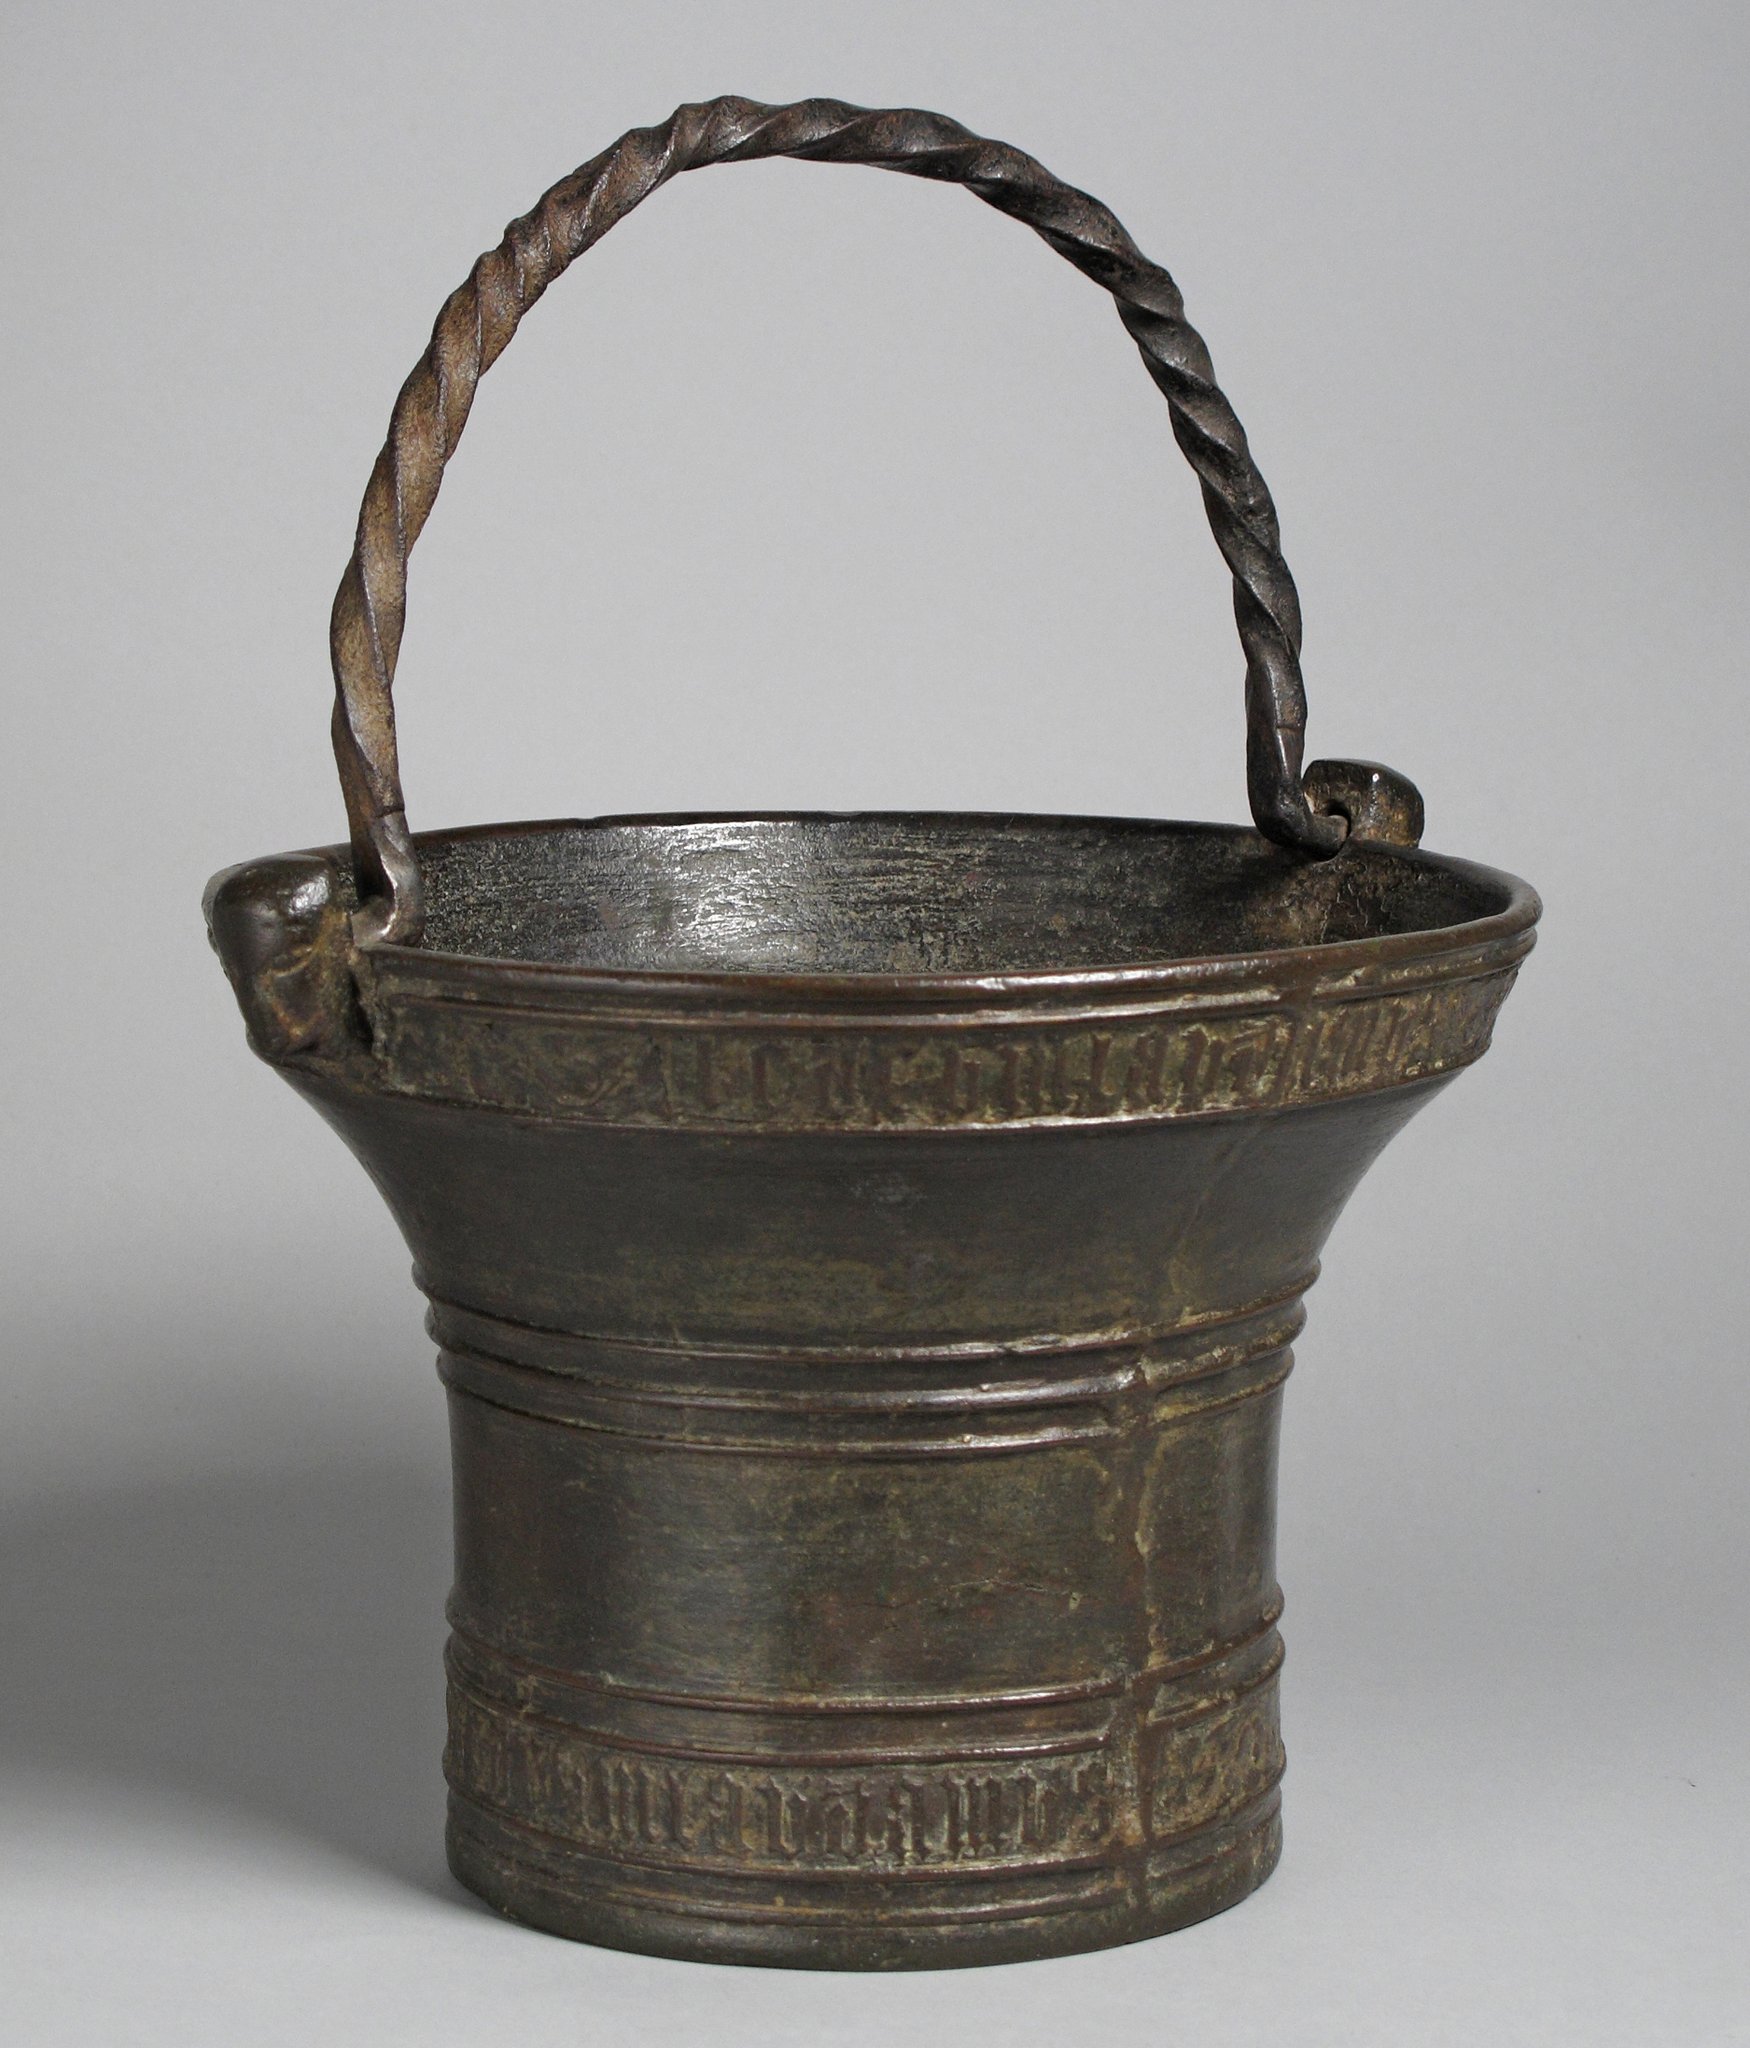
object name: situla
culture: dutch or french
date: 1450-1500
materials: brass, iron